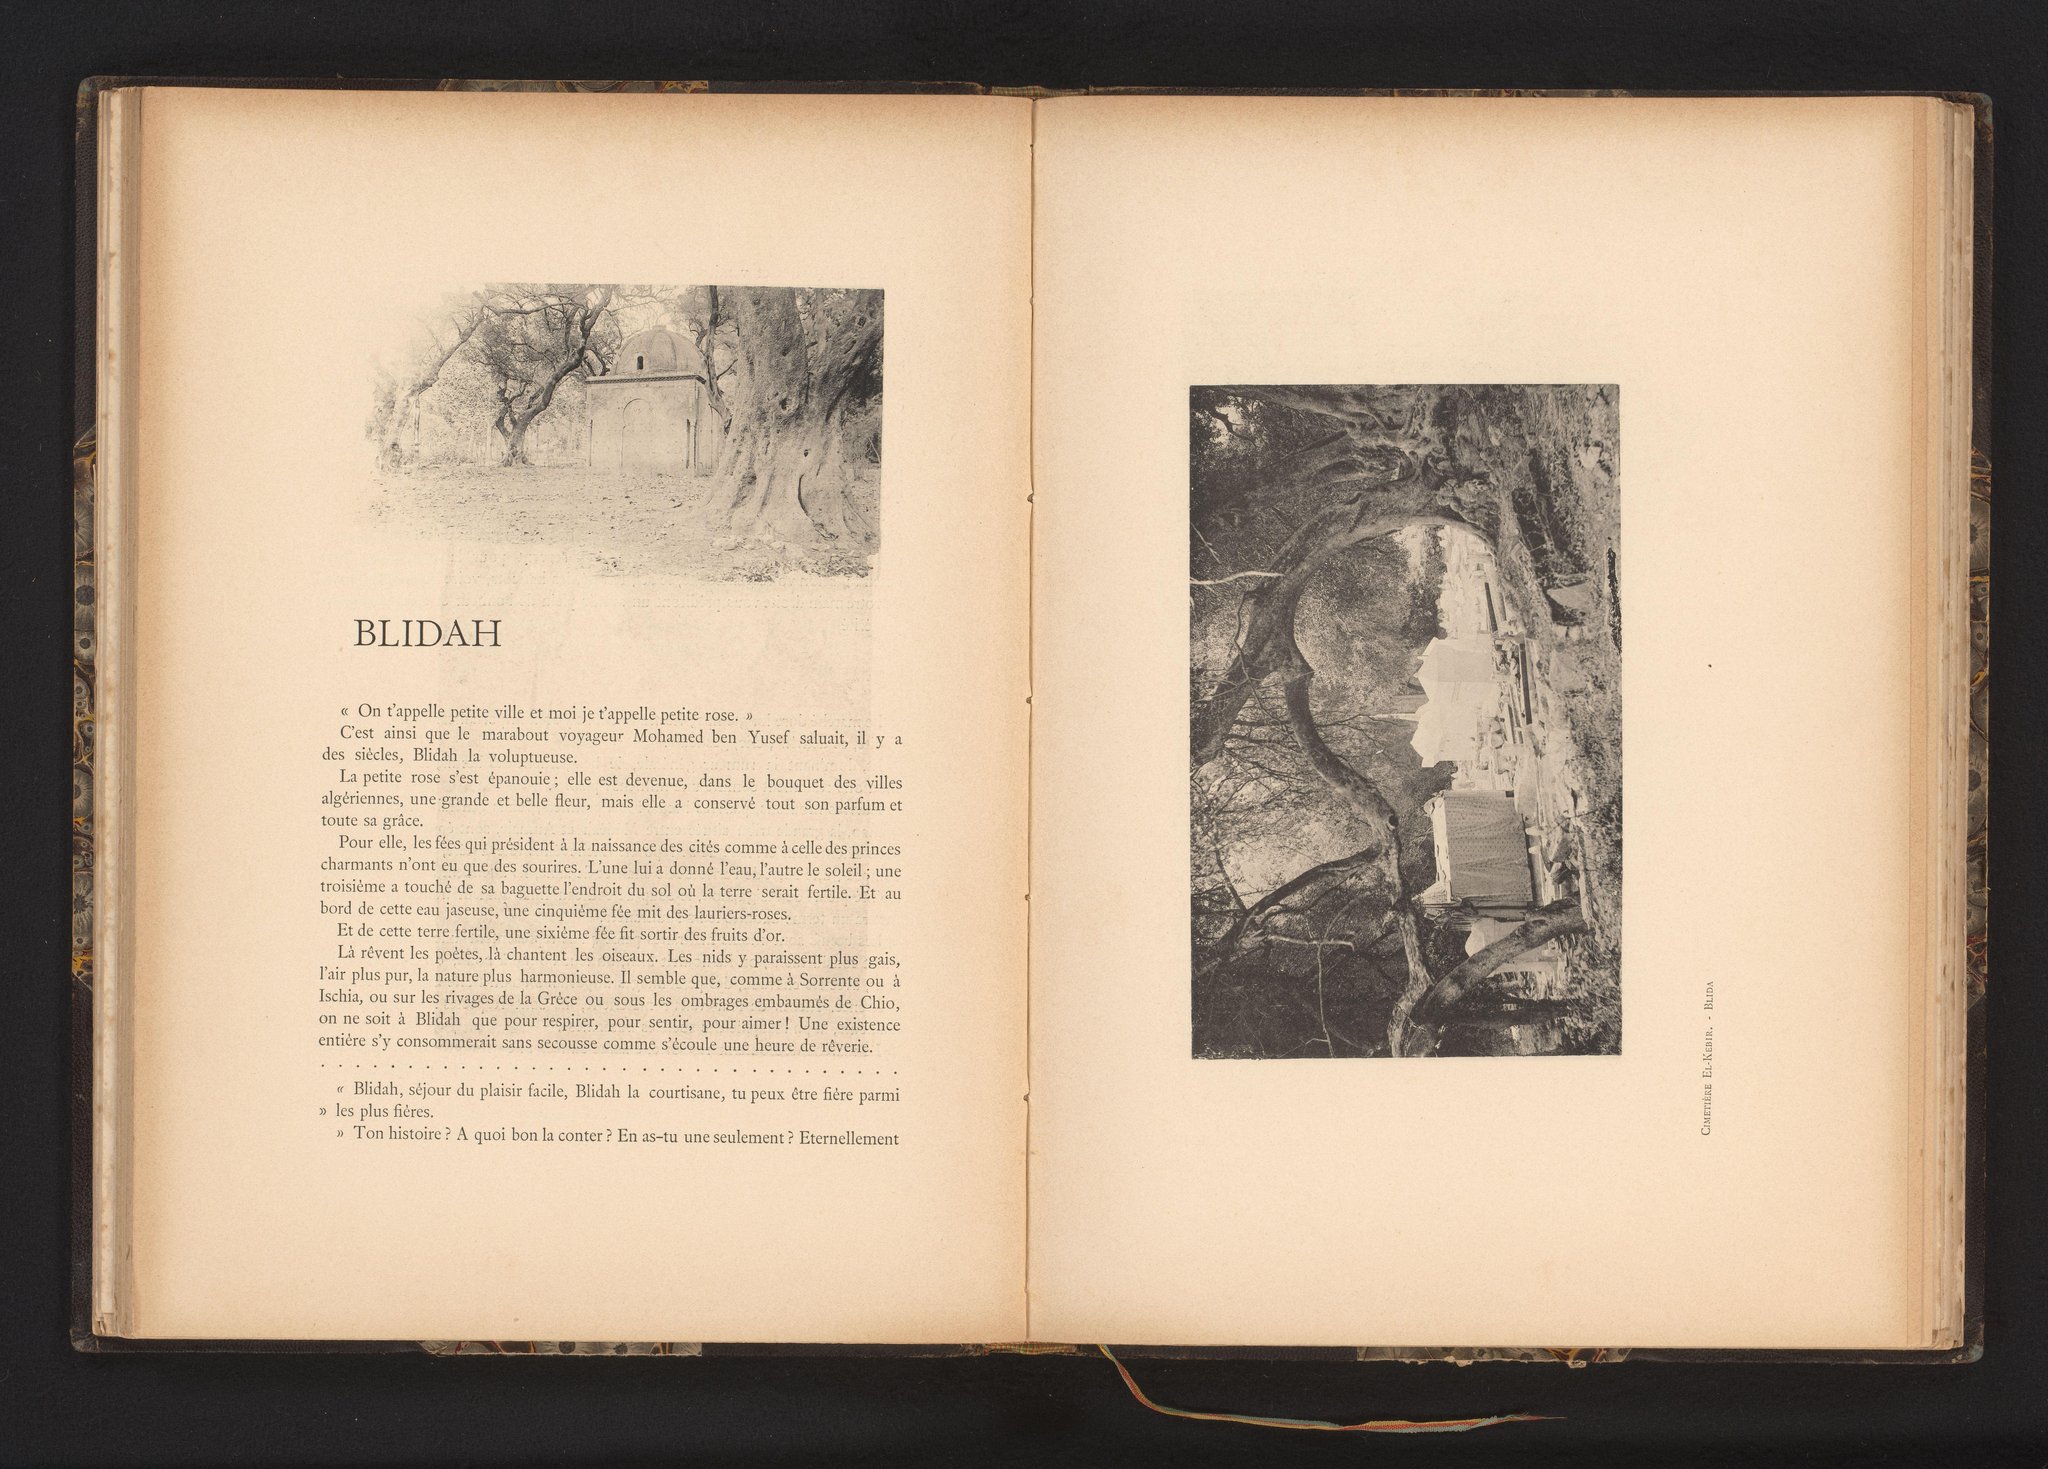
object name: photomechanical print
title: Cimetière El-Kebir. - Blida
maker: jules gervais-courtellemont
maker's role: fotograaf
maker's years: 1863-1931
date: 1888-1893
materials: paper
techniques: photograph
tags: churchyard, cemetery